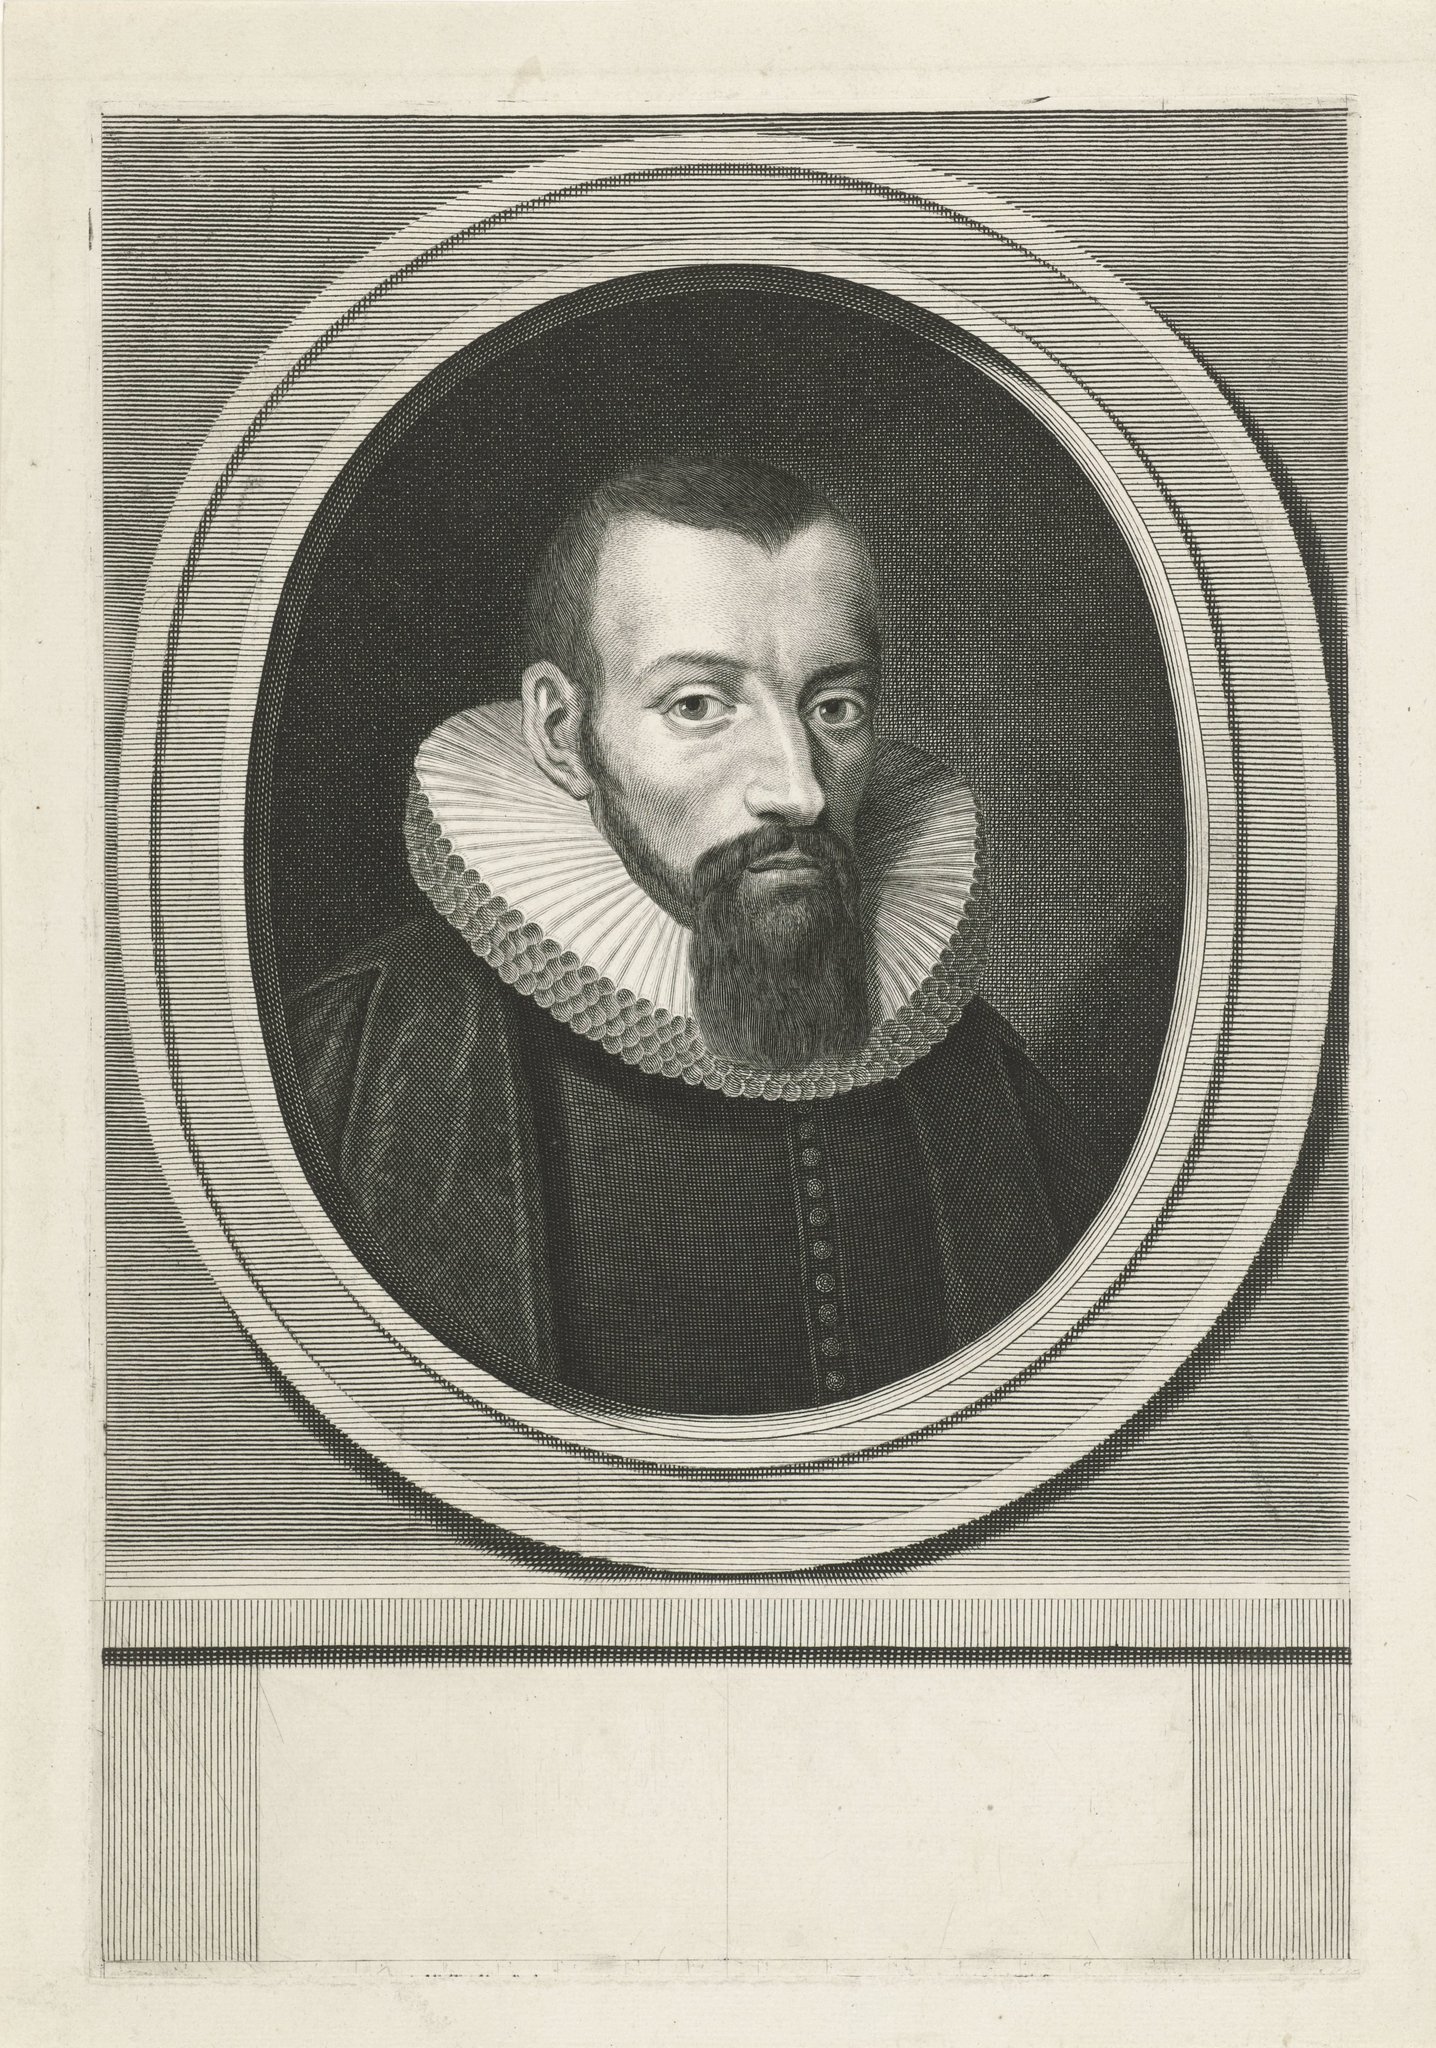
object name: print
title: Portret van Bartholomäus Keckermann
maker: jan van munnickhuysen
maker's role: draughtsman, print maker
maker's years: 1655-1701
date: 1664-1721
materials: paper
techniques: engraving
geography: netherlands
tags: danzig, filosoof, theoloog, bartholomäus keckermann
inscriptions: collector's mark: Lugt 2228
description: Portret van Bartholomäus Keckermann, protestants theoloog en filosoof te Danzig.